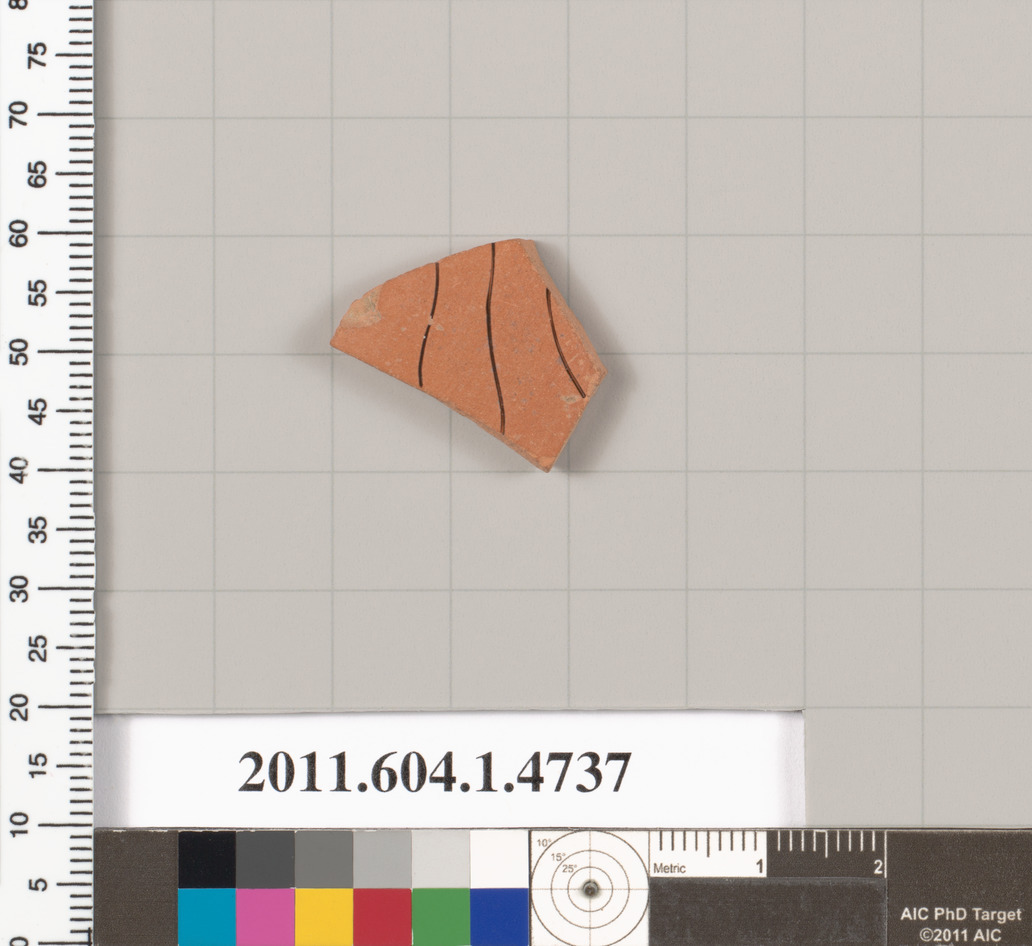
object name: kylix fragment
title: Terracotta fragment of a kylix (drinking cup)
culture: greek, attic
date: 475-451 BCE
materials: terracotta